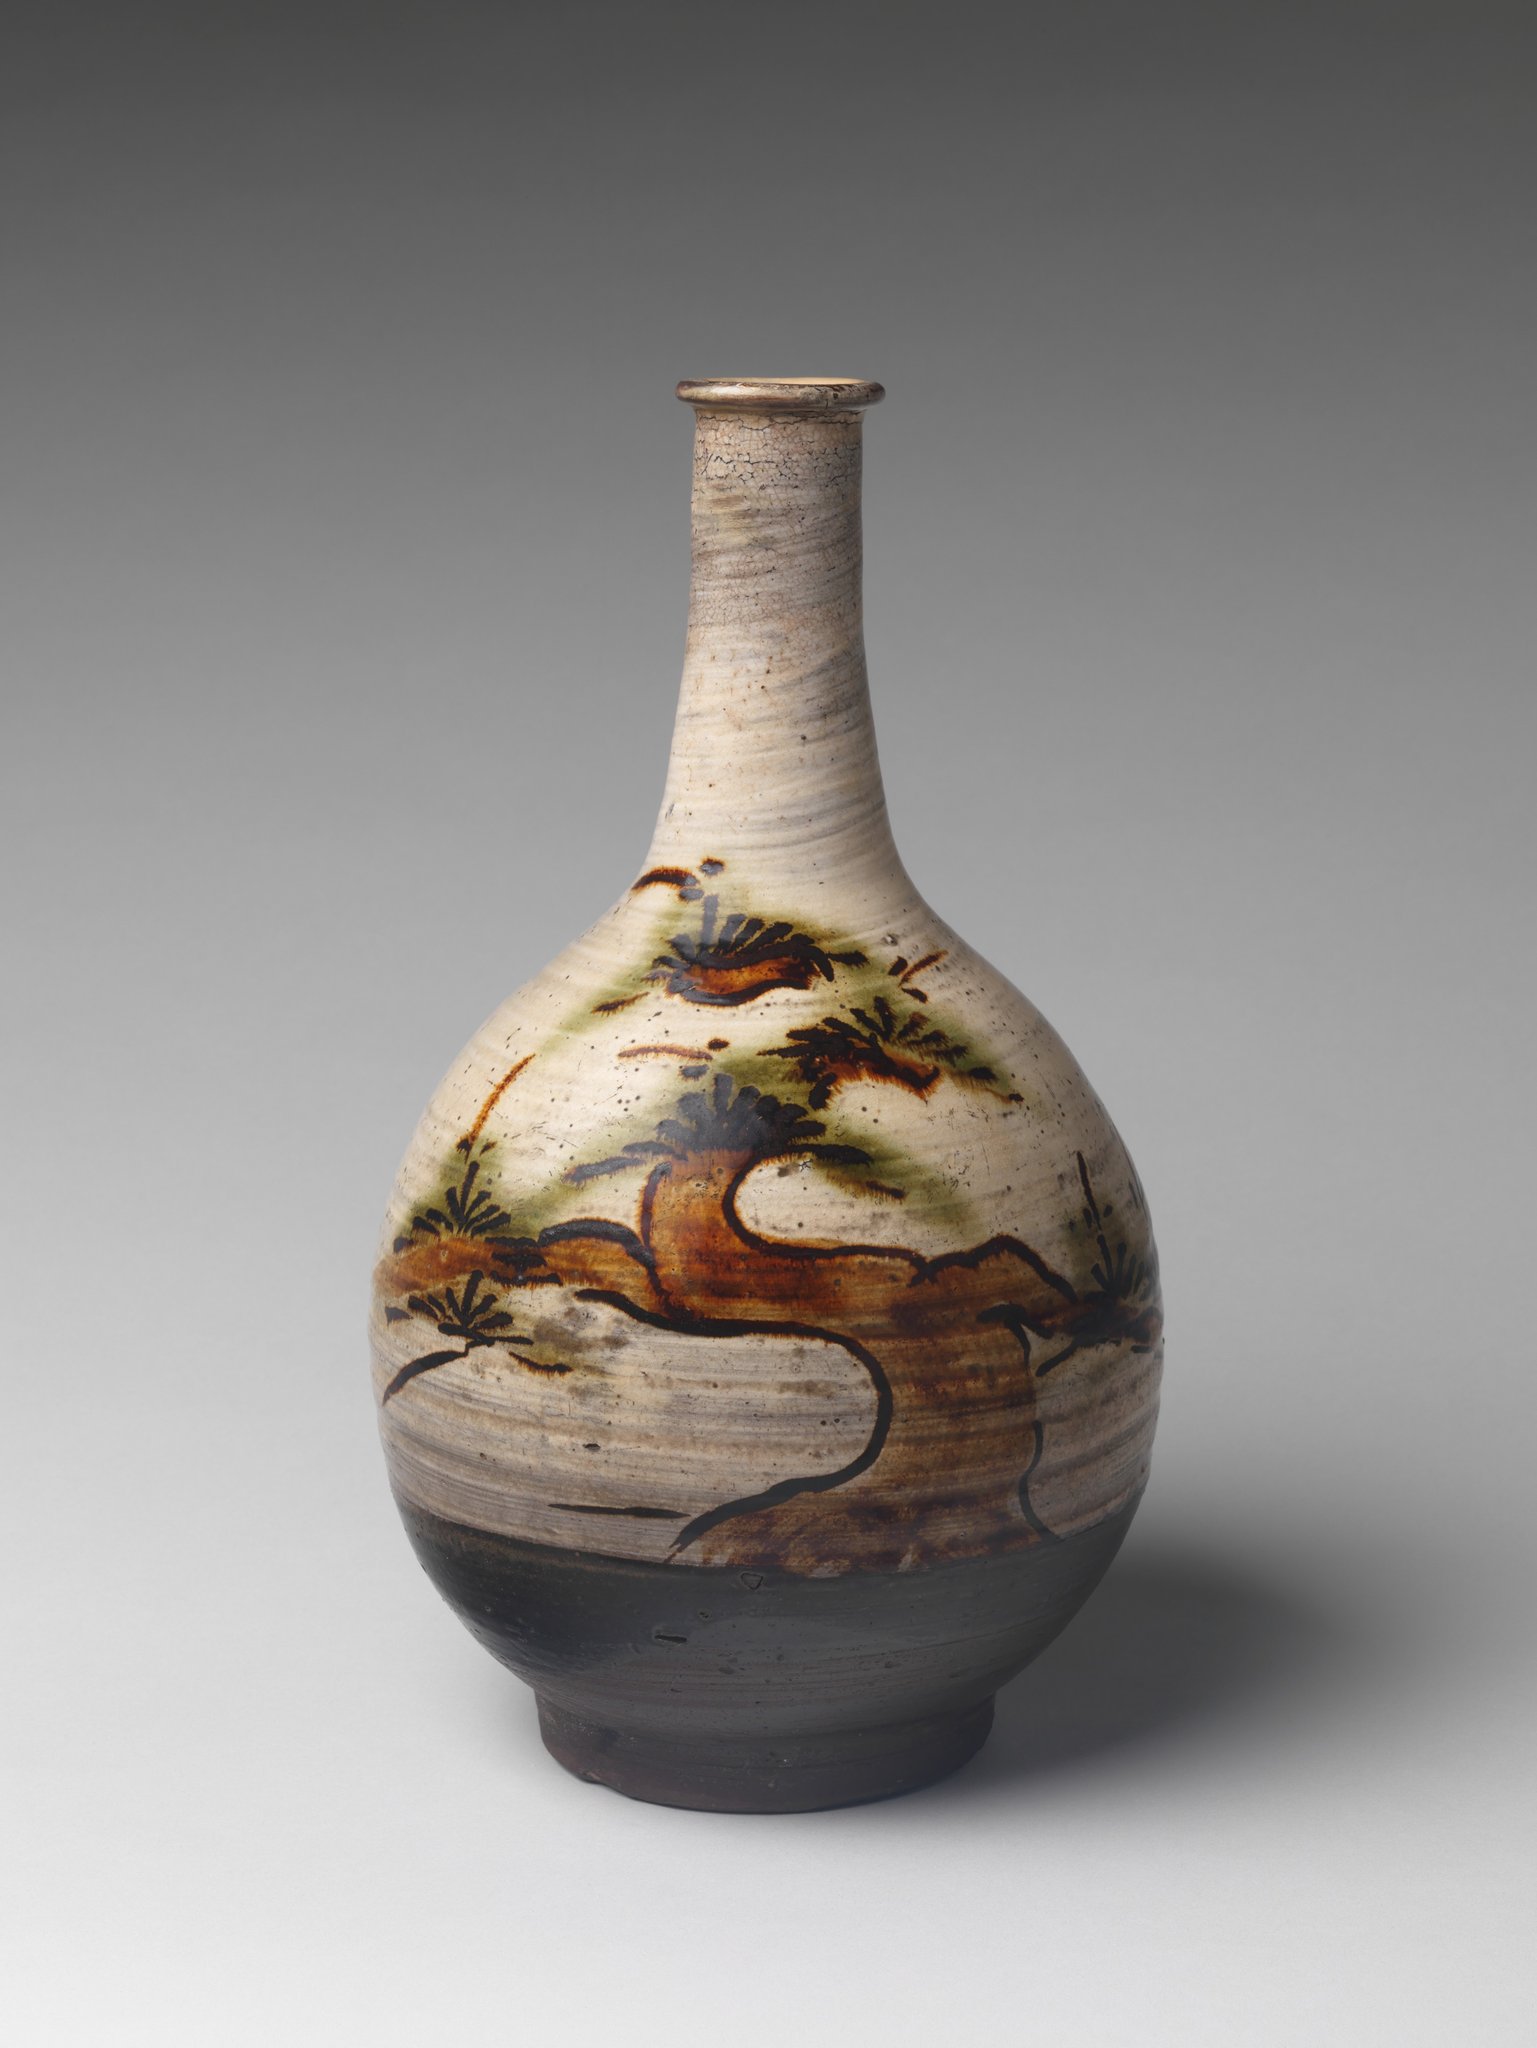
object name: bottle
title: Bottle with Decoration of Pine Tree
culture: japanese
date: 1634-1666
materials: copper, glaze, iron, stoneware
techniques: painting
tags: trees